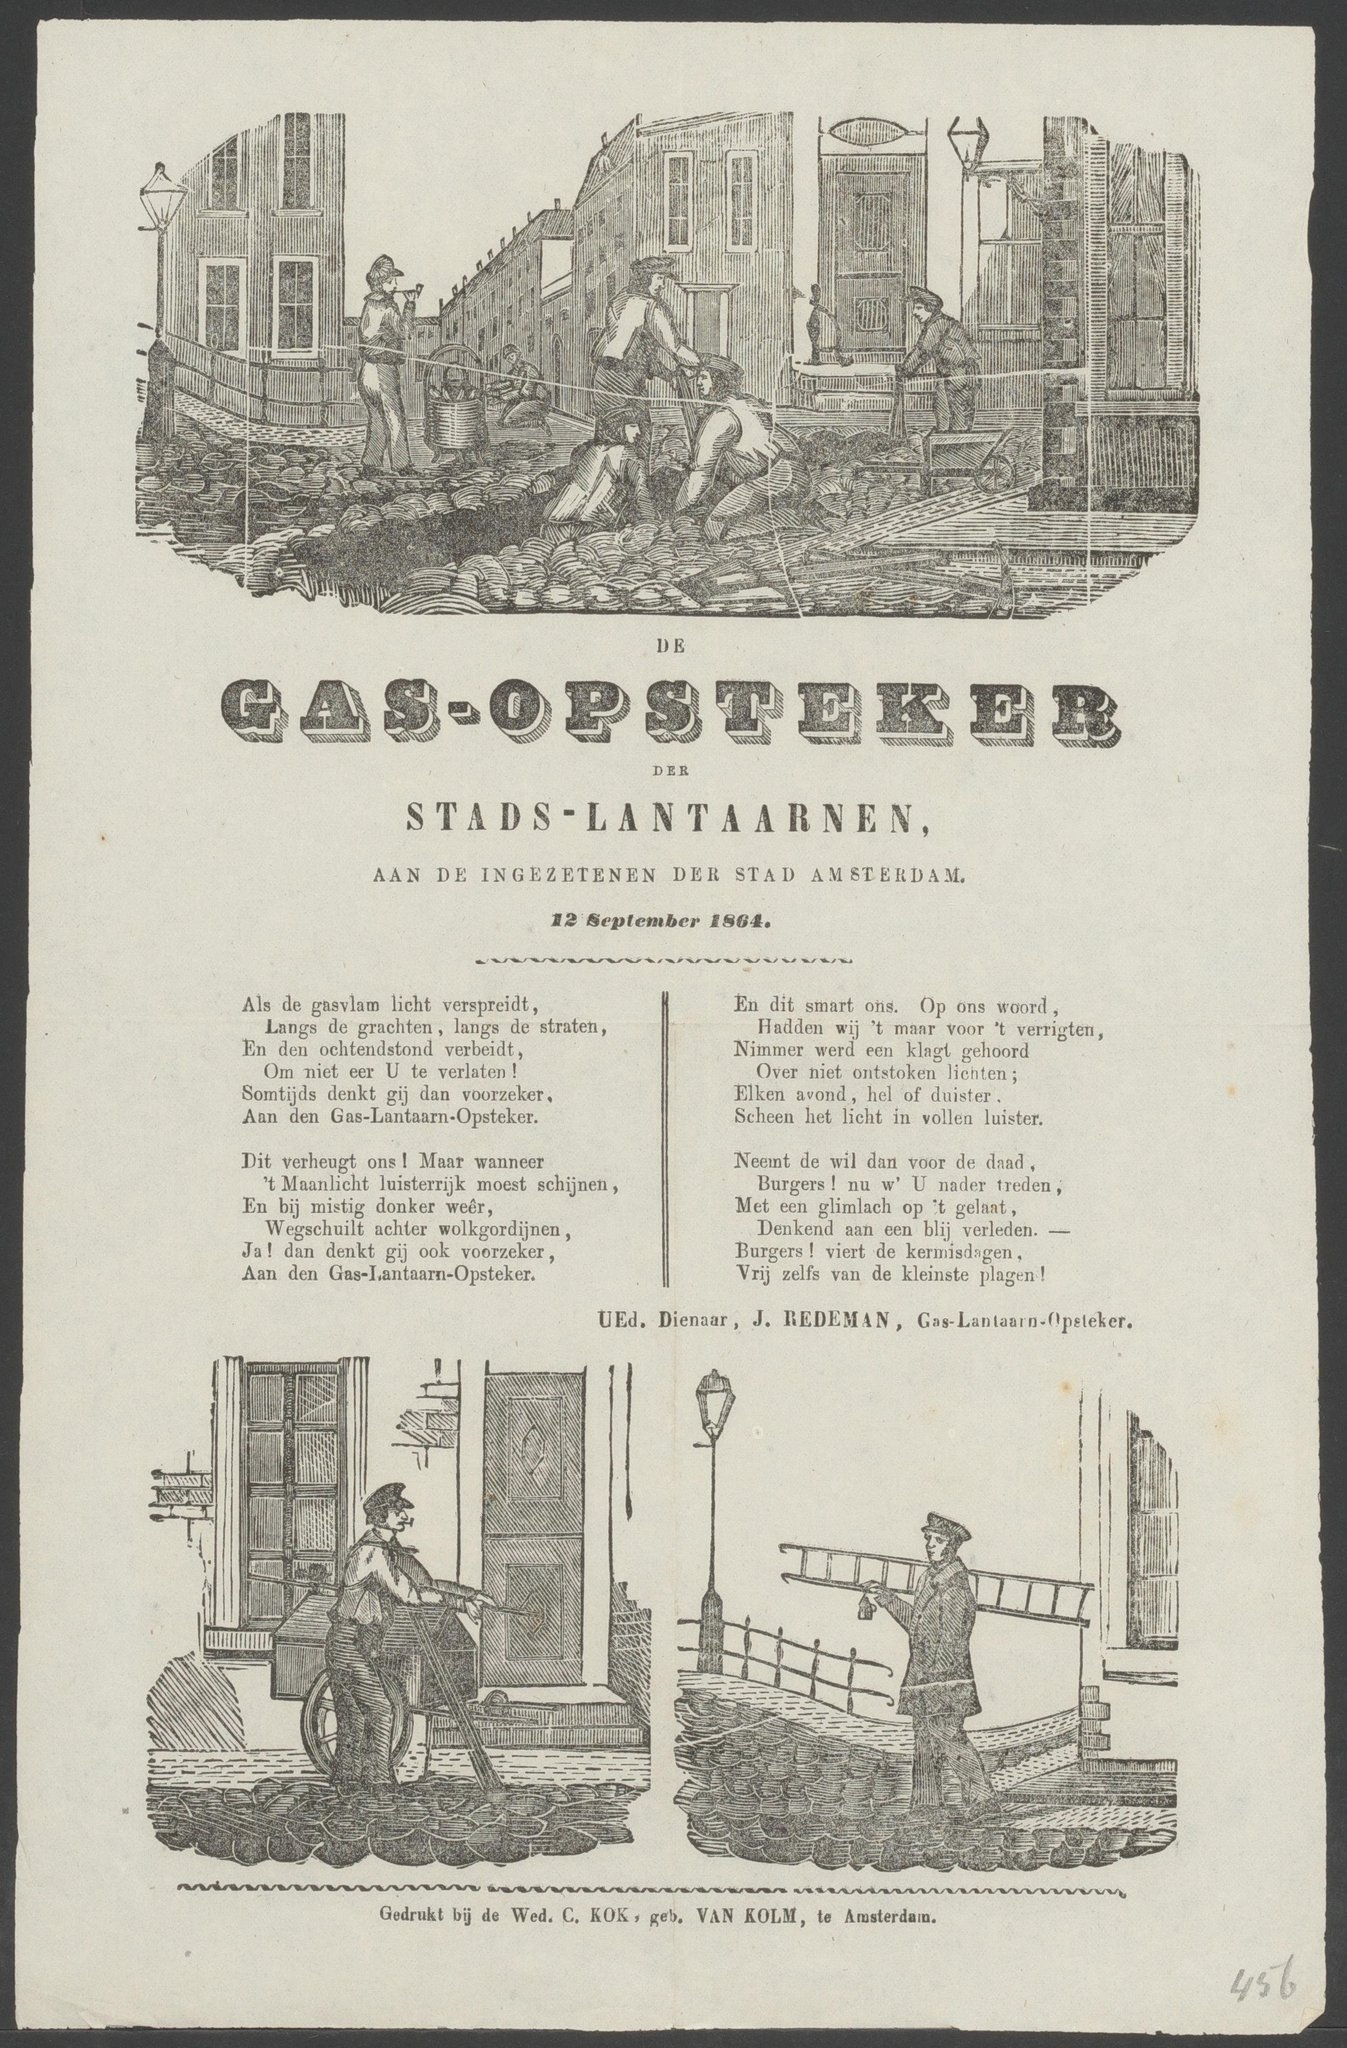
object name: print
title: De Gas-opsteker der Stads-lantaarnen, aan de ingezetenen der stad Amsterdam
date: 1864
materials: paper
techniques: letterpress printing, engraving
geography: amsterdam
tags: gas-lamp, gas supply, digging (industrial process), street lighting, amsterdam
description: Kermiswens van de Amsterdamse gaslantaarnopstekers voor het jaar 1864. Centraal een vers in twee kolommen. Bovenaan een straat in Amsterdam opgebroken voor de aanleg van de gasleiding. Onderaan twee gasfitters. Van de gaslantaarnopsteker: J. Redeman. Onderwerpsrubrieken binnen de Atlas Zeden en Gewoonten: Zeden en gewoonten in engeren zin, Volksleven, Volksbladen, Nieuwjaars- en Kerstwenschen, Amsterdam.